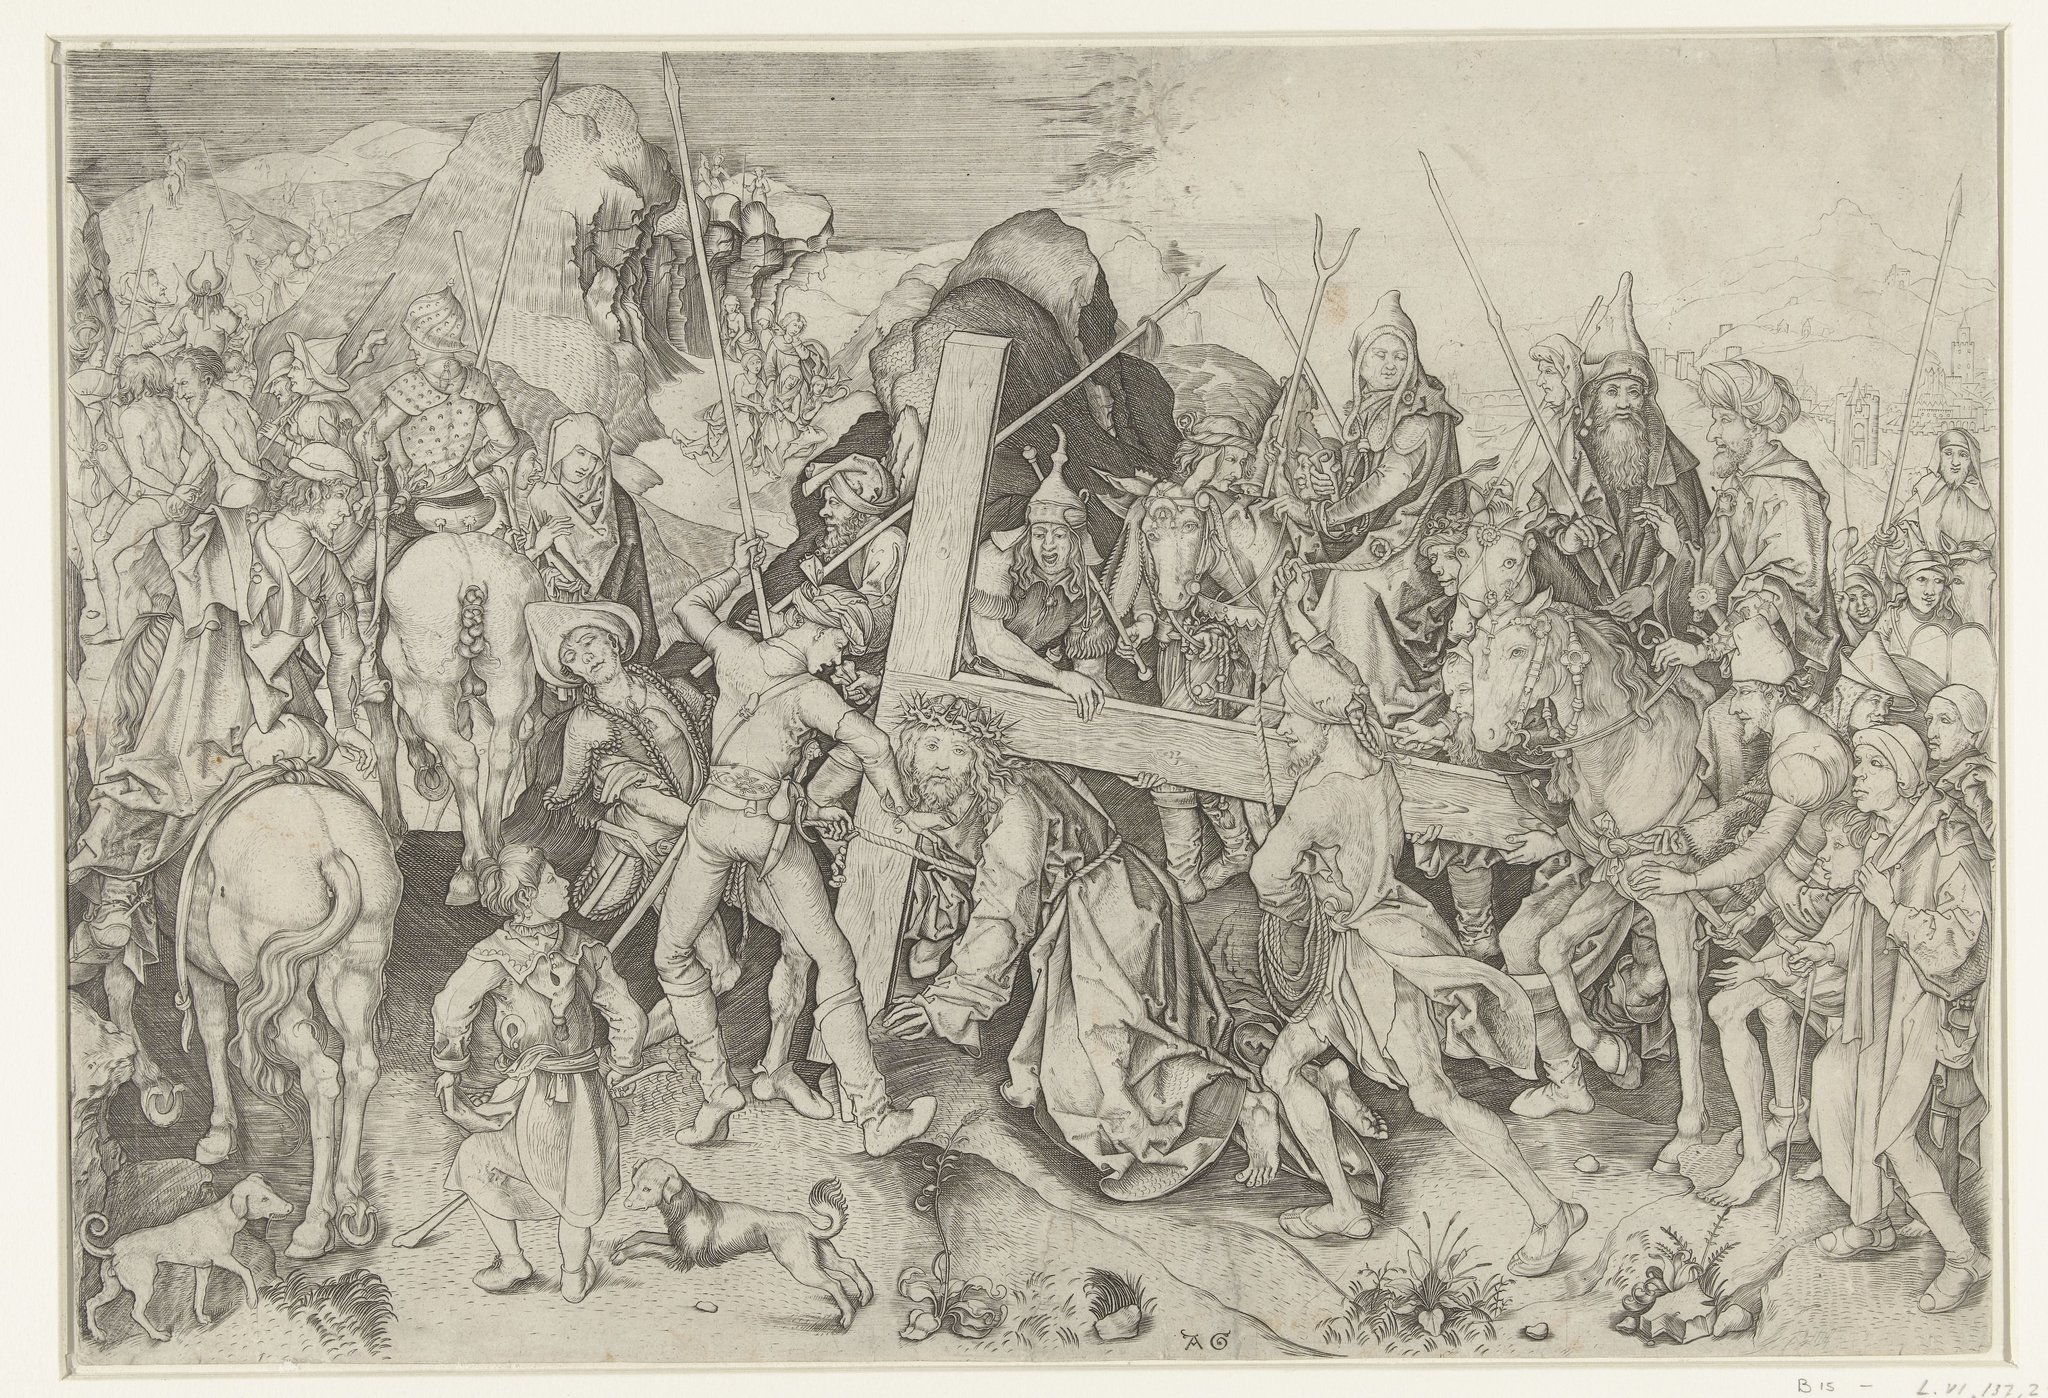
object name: print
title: Kruisdraging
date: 1470-1491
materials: paper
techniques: engraving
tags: carrying of the cross: christ bearing the cross, alone or with the help of others (e.g. simon the cyrenian)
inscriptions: collector's mark: Lugt 1264, collector's mark: Lugt 2228a, collector's mark: Lugt 2760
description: Christus bezwijkt onder het kruis op de weg naar Golgotha. Hij zit op zijn handen en knieën en kijkt de beschouwer aan. Soldaten manen hem met een zweep om weer op te staan en verder te gaan. Tussen de mensenmassa is nog net zichtbaar dat Simon van Cyrene Christus helpt met de kruisdraging. Rechts kijkt Pilatus te paard toe.